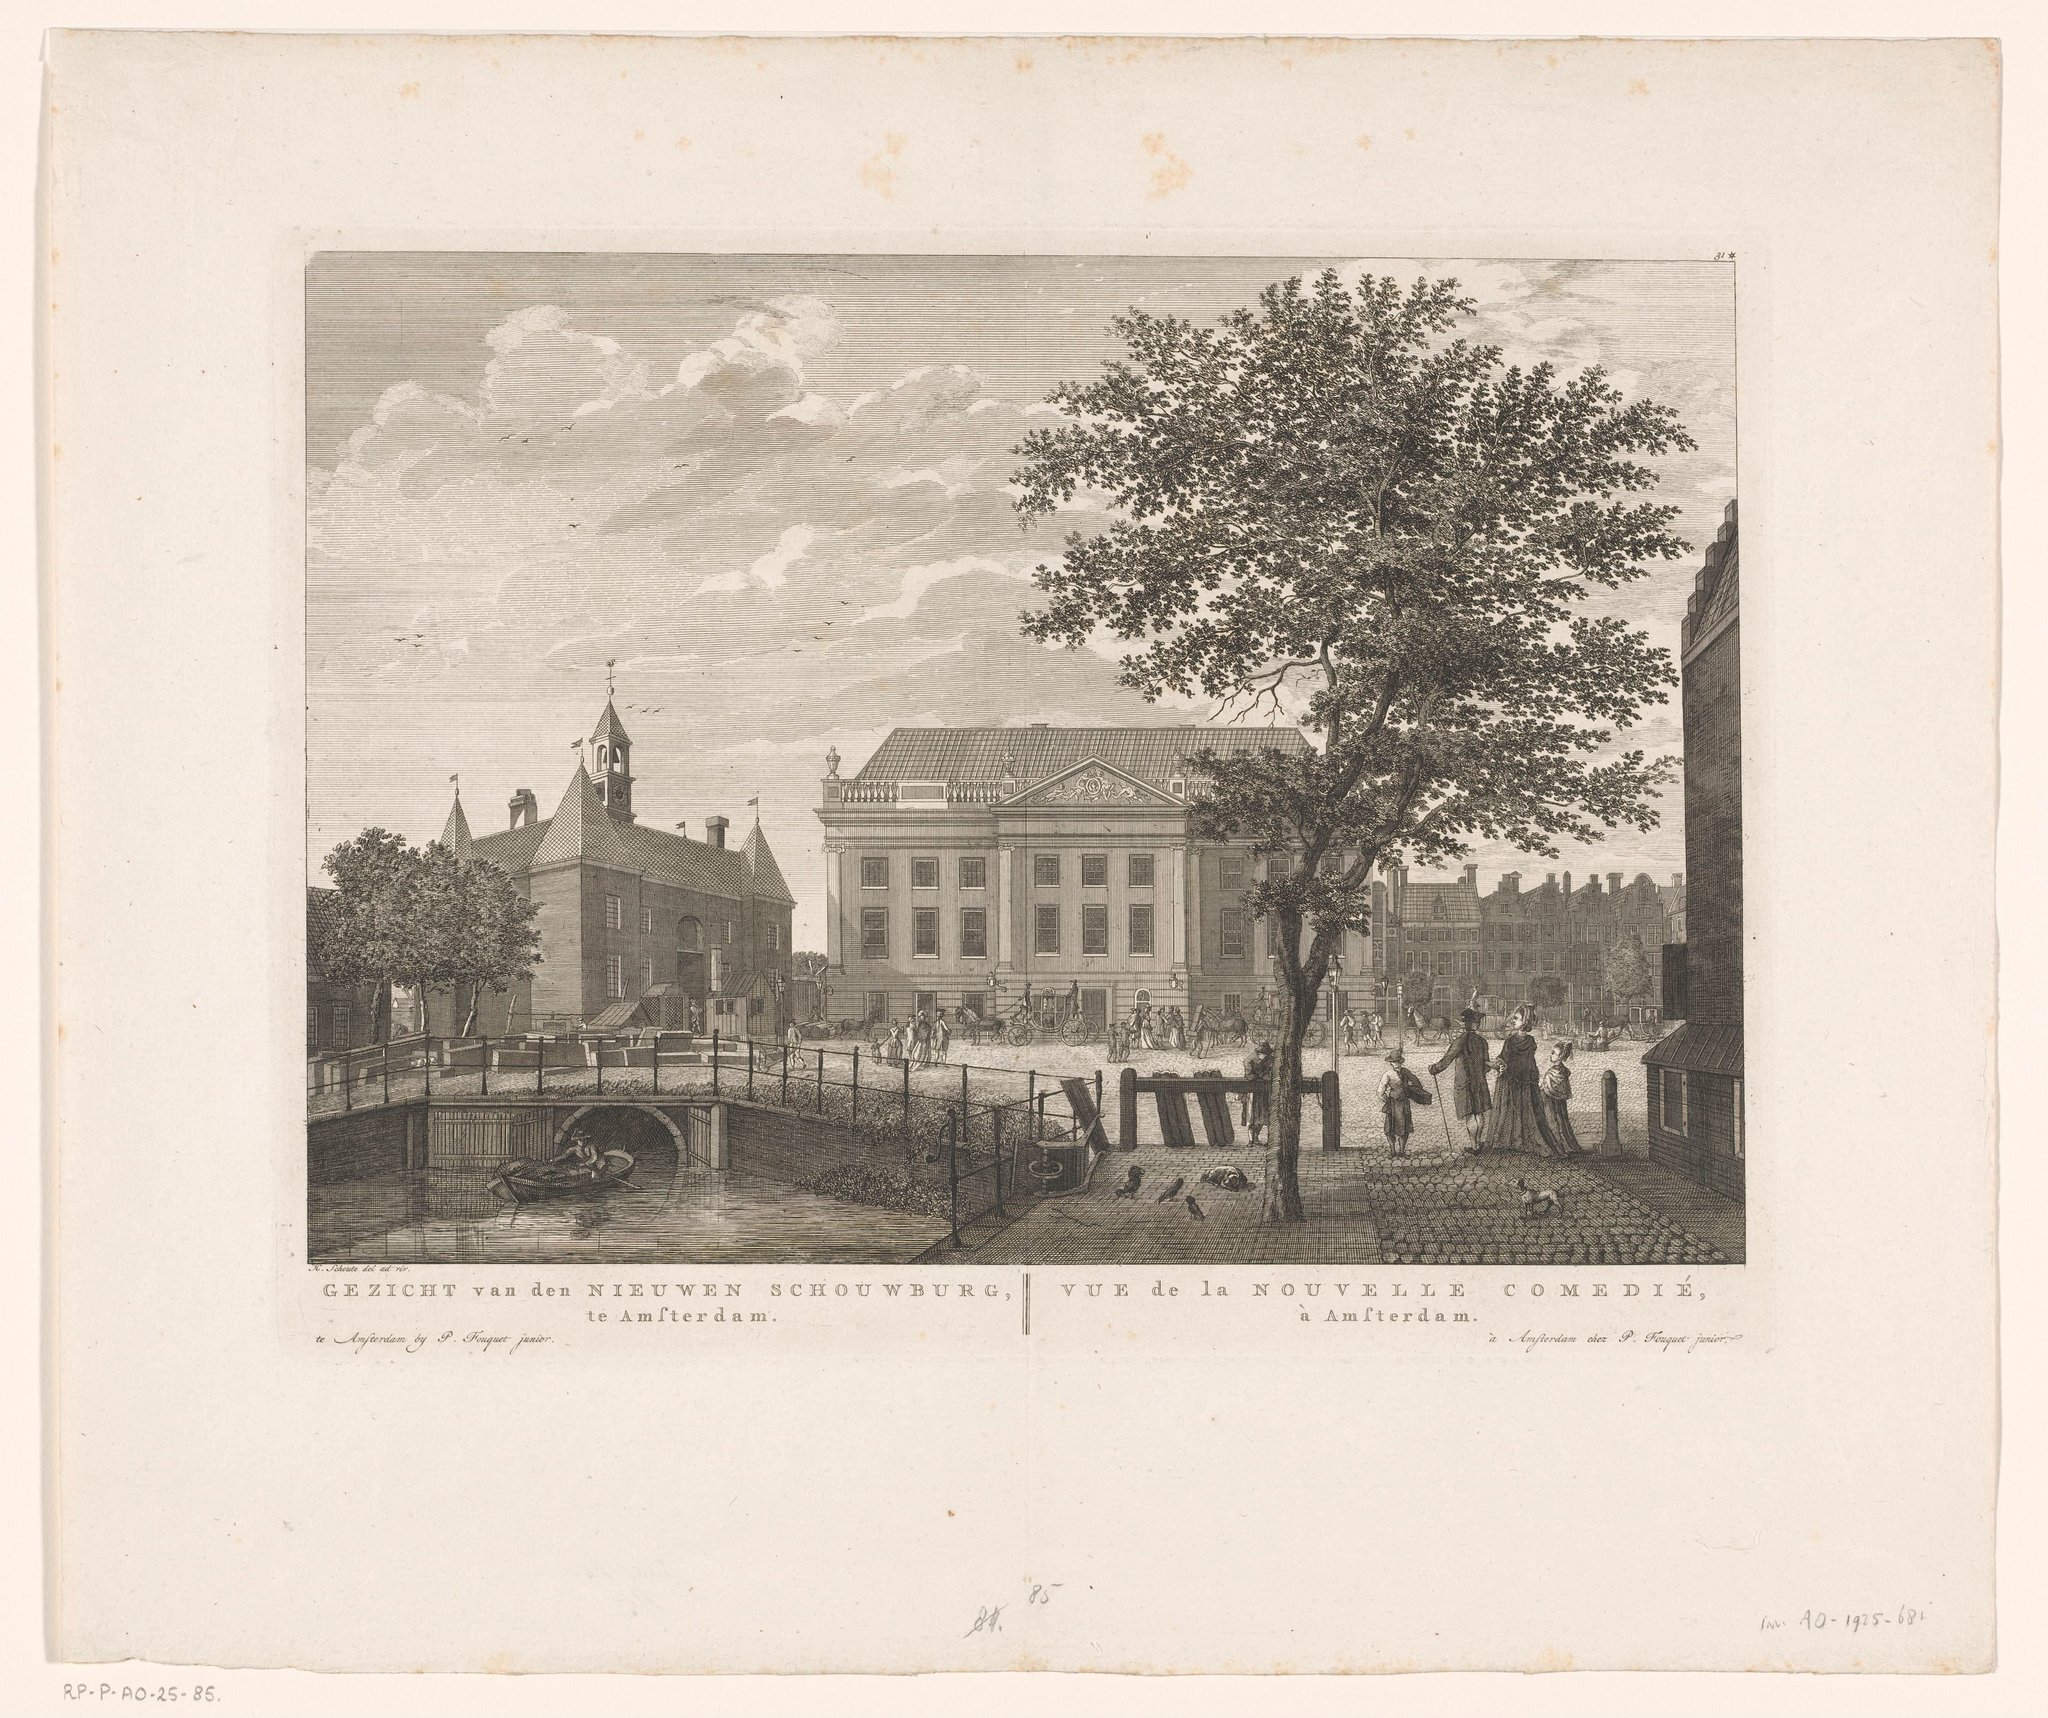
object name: print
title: Gezicht op de schouwburg aan het Leidseplein te Amsterdam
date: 1774-1783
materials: paper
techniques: engraving, etching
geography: amsterdam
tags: theatre (building), city-gate, square, place, circus, etc. (+ city(-scape) with figures, staffage), canals, waters (in city) (+ city(-scape) with figures, staffage), street (+ city(-scape) with figures, staffage)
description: Deze prent is ook gebruikt in de zogenaamde Atlas van Fouquet.* Pierre Fouquet gaf vanaf 1760 stadsgezichten van Amsterdam - naar tekeningen van verschillende kunstenaars, gemaakt door verschillende prentmakers - uit. Deze prenten werden aanvankelijk los of in series verkocht. Zoals toen gebruikelijk kon de koper de prenten zelf laten inbinden. Hiertoe gaf Fouquet tussen 1778 en 1783 een titelblad, plattegrond en inhoudsopgave van de tot dusver 100 uitgegeven prenten uit (1). Gezien de inhoud afhankelijk was van wat de koper had verzameld verschilt de inhoud van de verschillende bewaarde Fouquetatlassen onder deze titel sterk. Ook zijn er exemplaren bekend waar tevens andere prenten aan zijn toegevoegd. Omdat er behoefte bleek aan uitleg bij de platen werd in 1783 een nieuwe versie van de atlas uitgegeven, aangevuld met tekst en twee prenten. De aangegeven volgorde veranderde maar de platen van de al eerder uitgegeven prenten bleven ongewijzigd. Deze uitgave werd in opdracht van Fouquet gedrukt bij Daniël Jean Changuion en Petrus den Hengst (2). Een tiental platen werd bijgewerkt en verscheen, met nieuw impressum, in het vervolg van Wagenaars geschiedenis van Amsterdam, uitgeven door Petrus Conradi en Folkert van der Plaats (3). Een aantal jaar na het overlijden van Fouquet kwam Evert Maaskamp met een nieuwe uitgave van de atlas, met verbeterde tekst en toevoeging van twee prenten. Op alle platen verwijderde hij het oude en liet hij zijn eigen impressum zetten (4). De huidige staat van de prent komt voor in exemplaren van de onder (1) en (2) genoemde werken. * Onder de Atlas van Fouquet of Fouquetatlas verstaan we de hieronder vermelde publicaties (1), (2) en (4). (1). Afbeeldingen van de wyd-vermaarde koopstad Amsterdam benevens des zelvs voornaamste gebouwen en gezigten alle naar het leeven getekend / Receuil des edifices les plus considerables et des plus belles vues, de la fameuse ville d'Amsterdam, dessinées d'après nature. Amsterdam: Pierre Fouquet, 1778-1783. (2). Nieuwe atlas, van de voornaamste gebouwen en gezigten der stad Amsterdam, met derzelver beknopte beschryvingen. 2 delen. Amsterdam: Daniël Jean Changuion en Petrus den Hengst [in opdracht van Pierre Fouquet], 1783. (3). Stijl, Simon. Amsterdam, in zyne geschiedenissen, voorregten, koophandel, gebouwen, kerkenstaat, schoolen, schutterye, gilden en regeeringe, beschreeven. Om te dienen ten vervolge op het werk van Jan Wagenaar (…). 10 delen. Amsterdam en Harlingen: Petrus Conradi en Folkert van der Plaats, 1788-1801. (4). Nieuwe atlas, van de voornaamste gebouwen en gezigten der stad Amsterdam. Met derzelver beknopte beschryvingen. Amsterdam: Evert Maaskamp, 1805. * Het aantal vermelde staten is gebaseerd op het aantal gevonden staten. Mogelijk zijn er meer staten van deze prent.